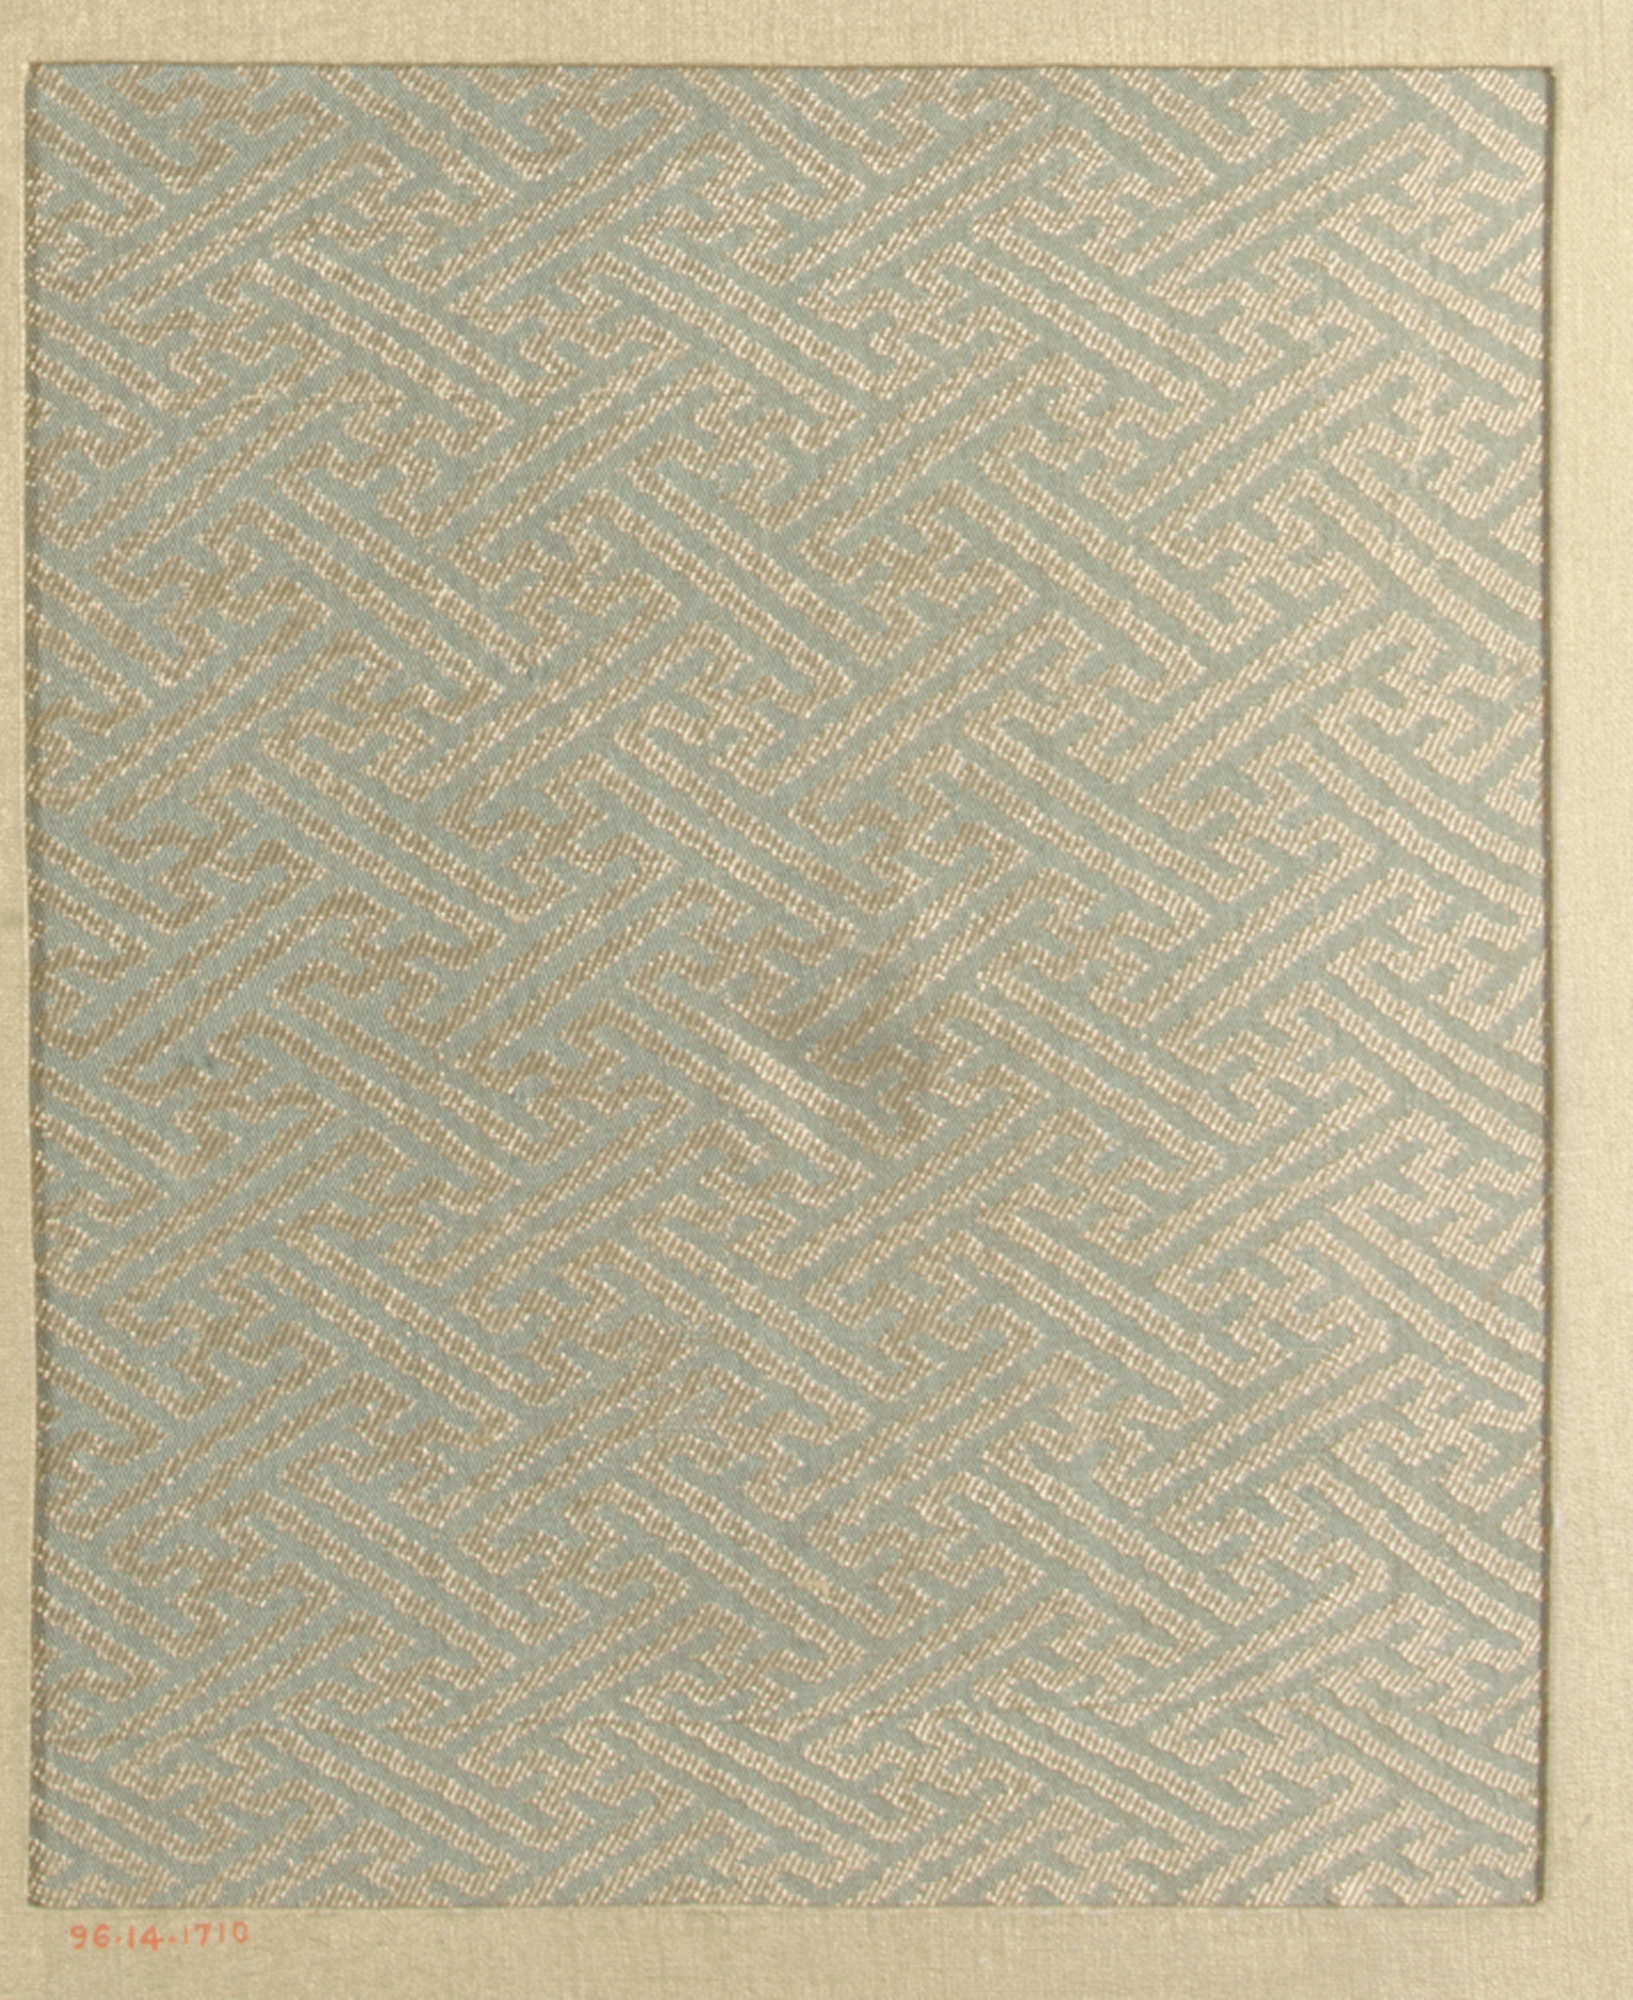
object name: piece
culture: japanese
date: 1701-1900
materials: silk